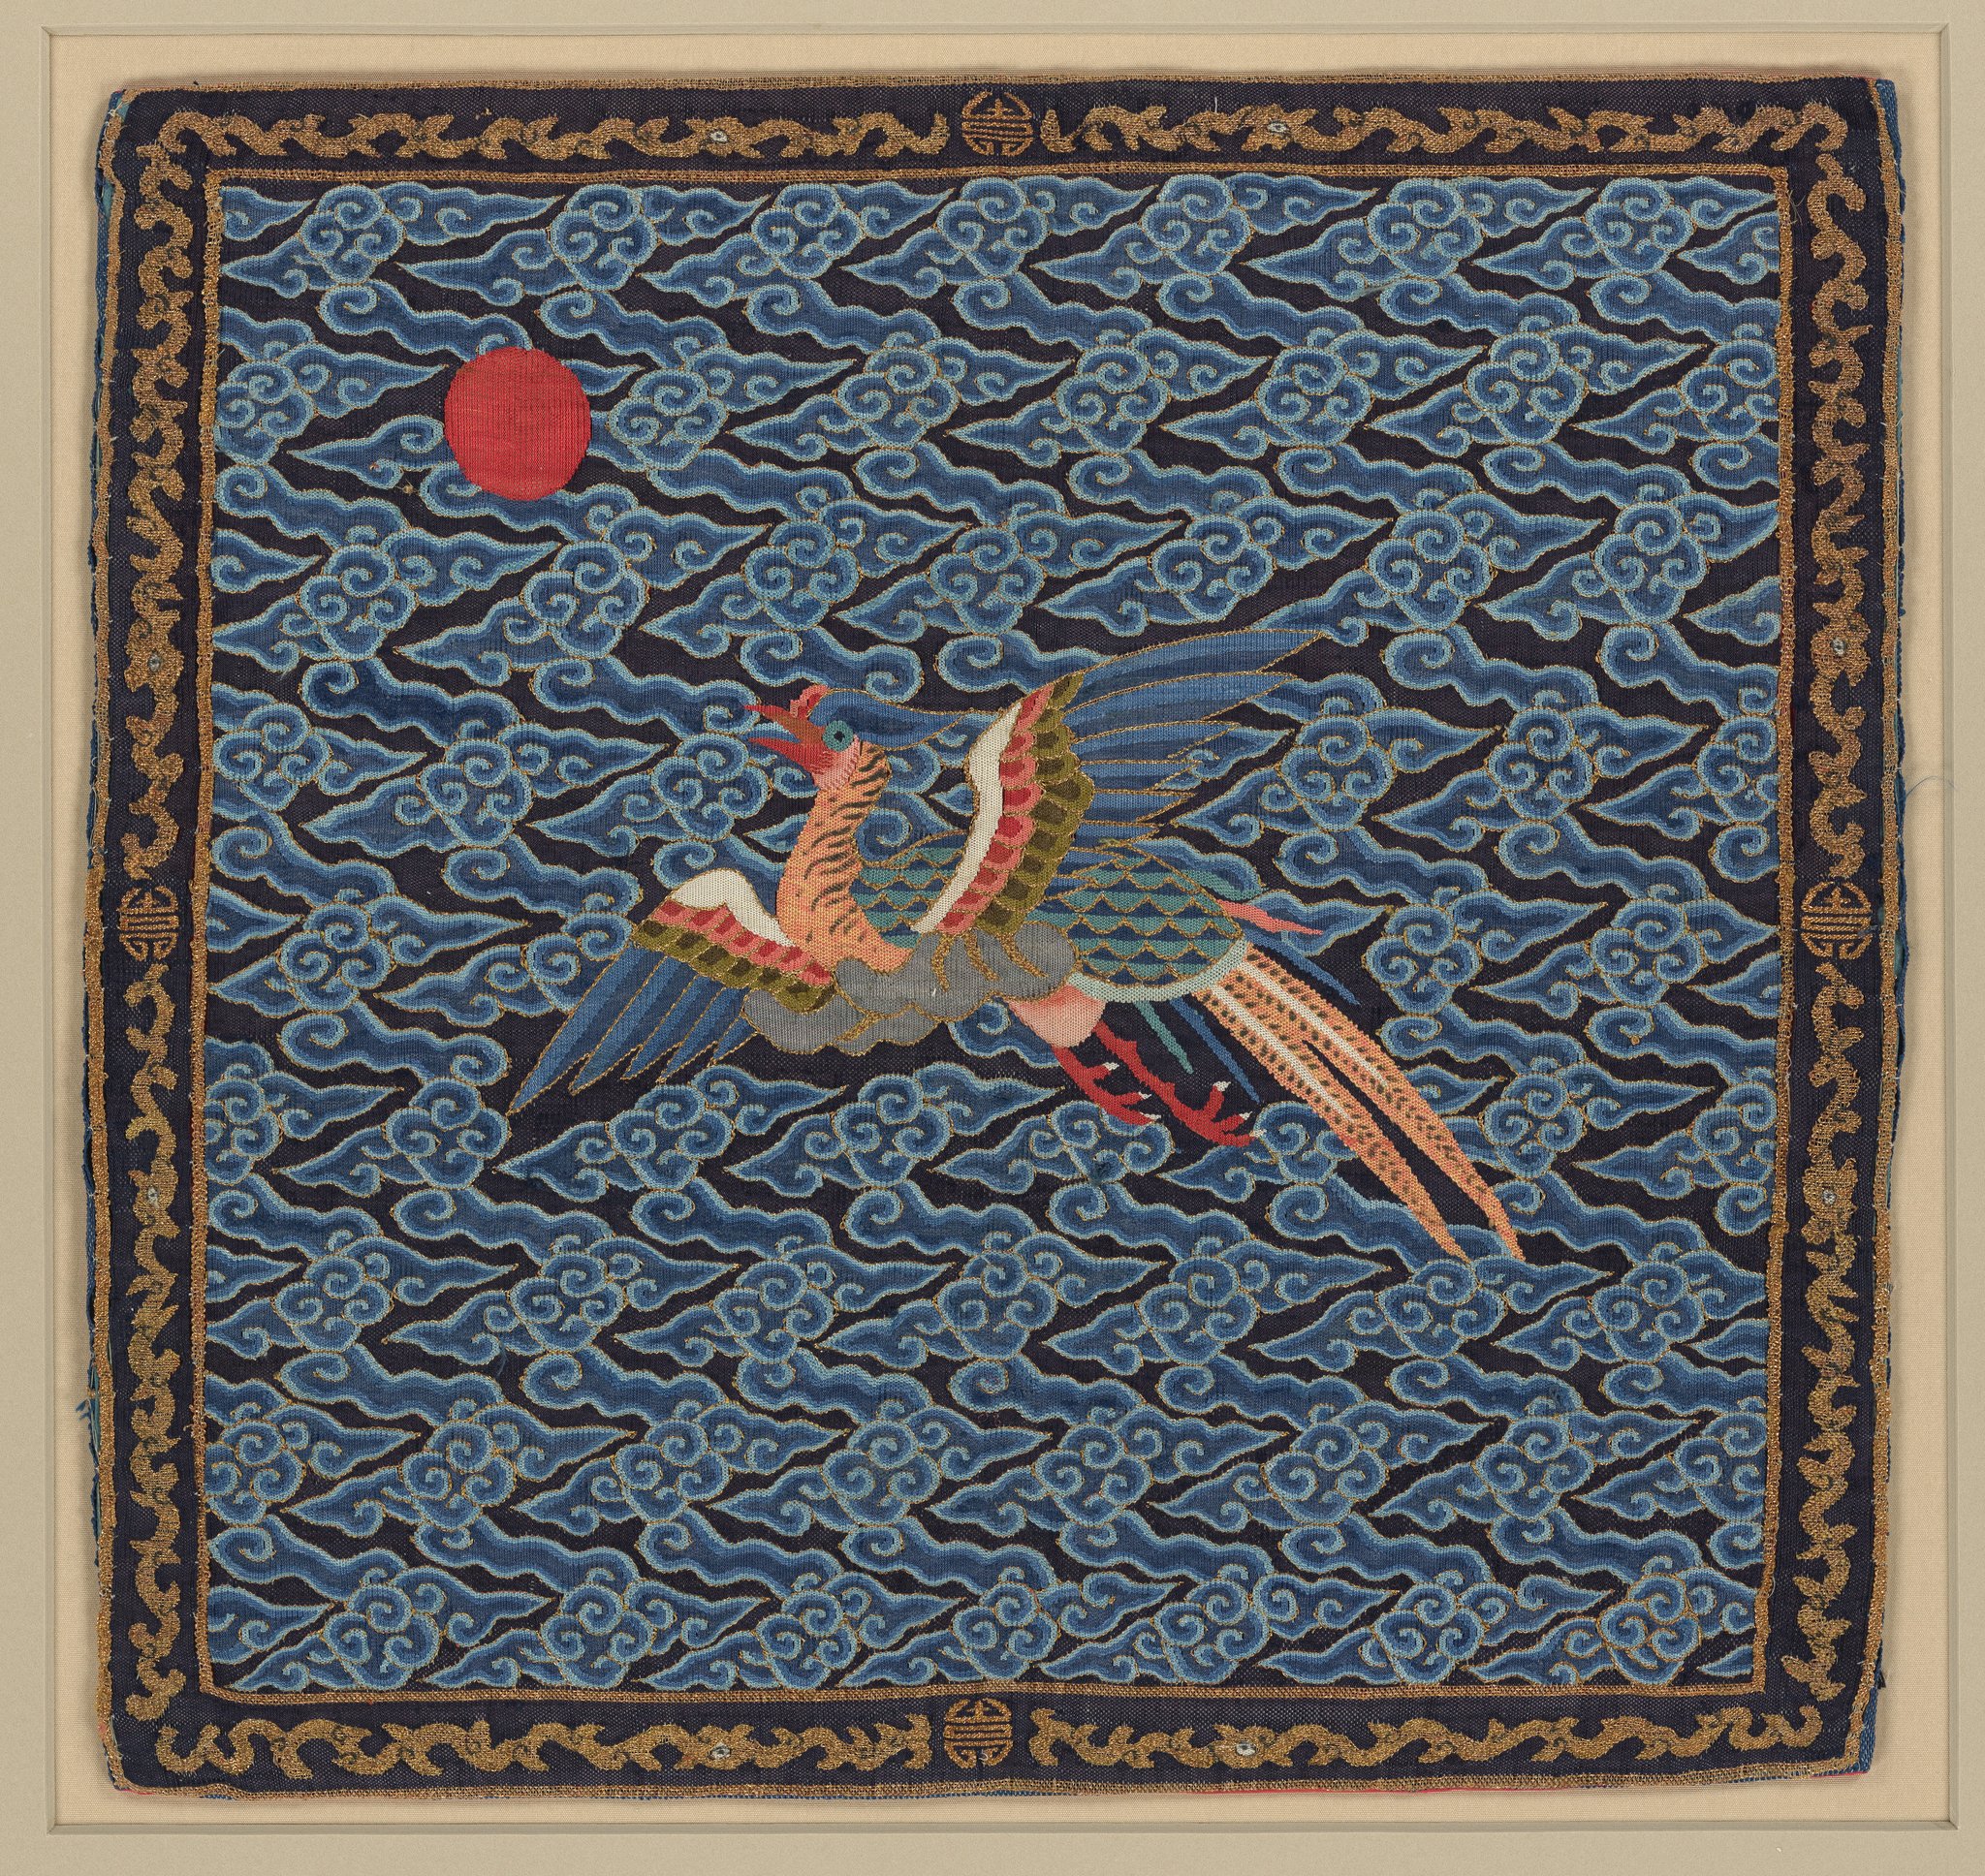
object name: civil rank badge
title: Rank badge with pheasant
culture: chinese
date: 1801-1900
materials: metal thread, silk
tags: pheasants